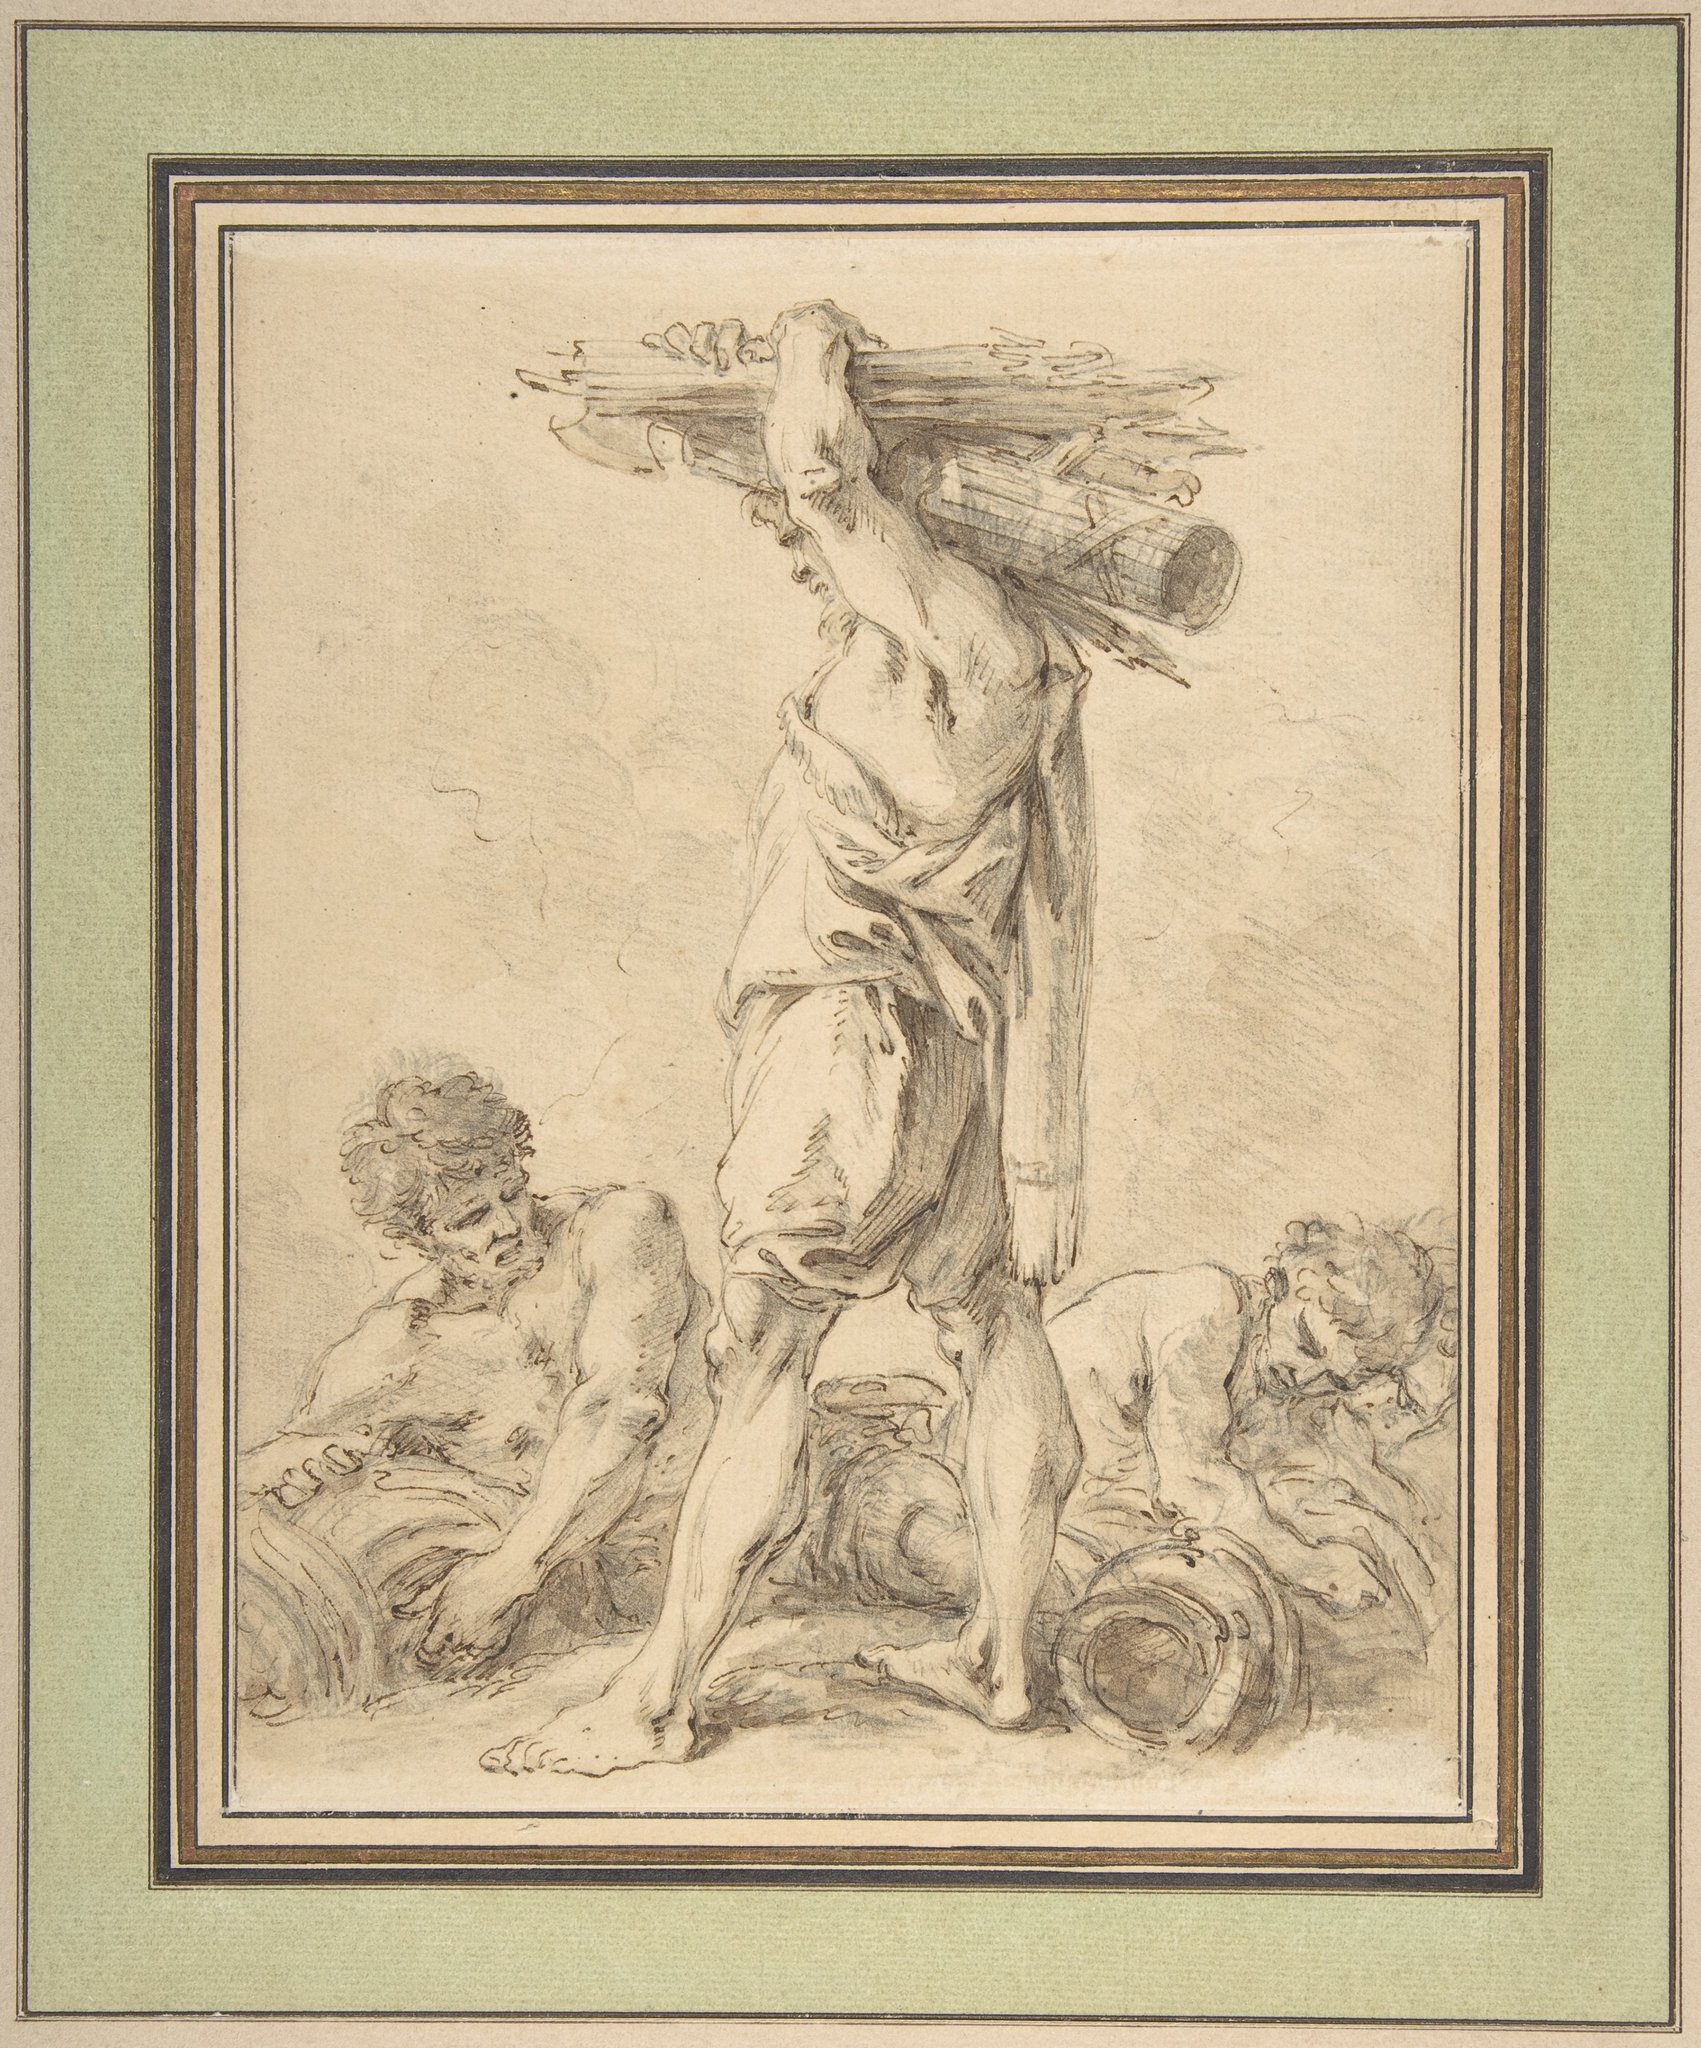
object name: drawing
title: Standing Man Carrying Fasces and Arms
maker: françois boucher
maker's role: artist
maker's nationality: french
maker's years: 1703-1770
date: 1700-1770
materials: chalk, ink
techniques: pen, wash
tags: men